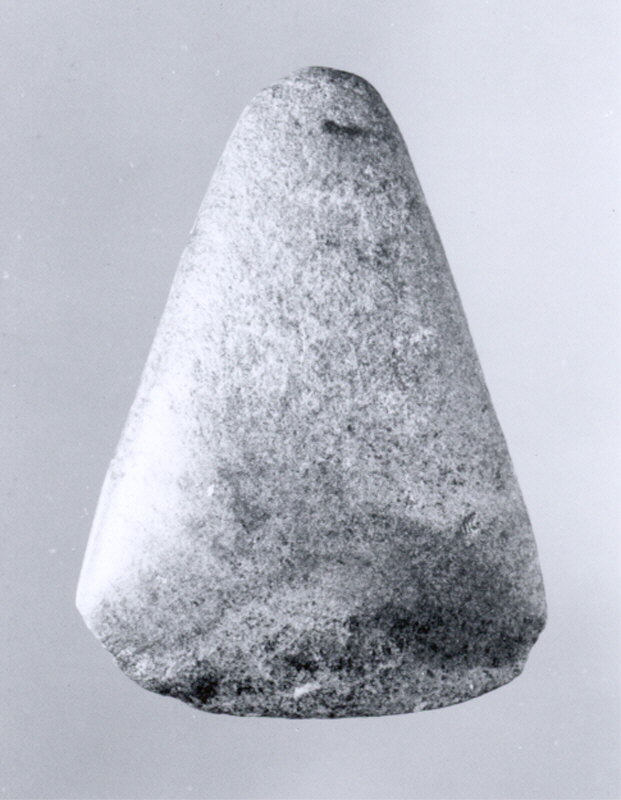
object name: chisel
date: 3000-2001 BCE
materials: stone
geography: anatolia